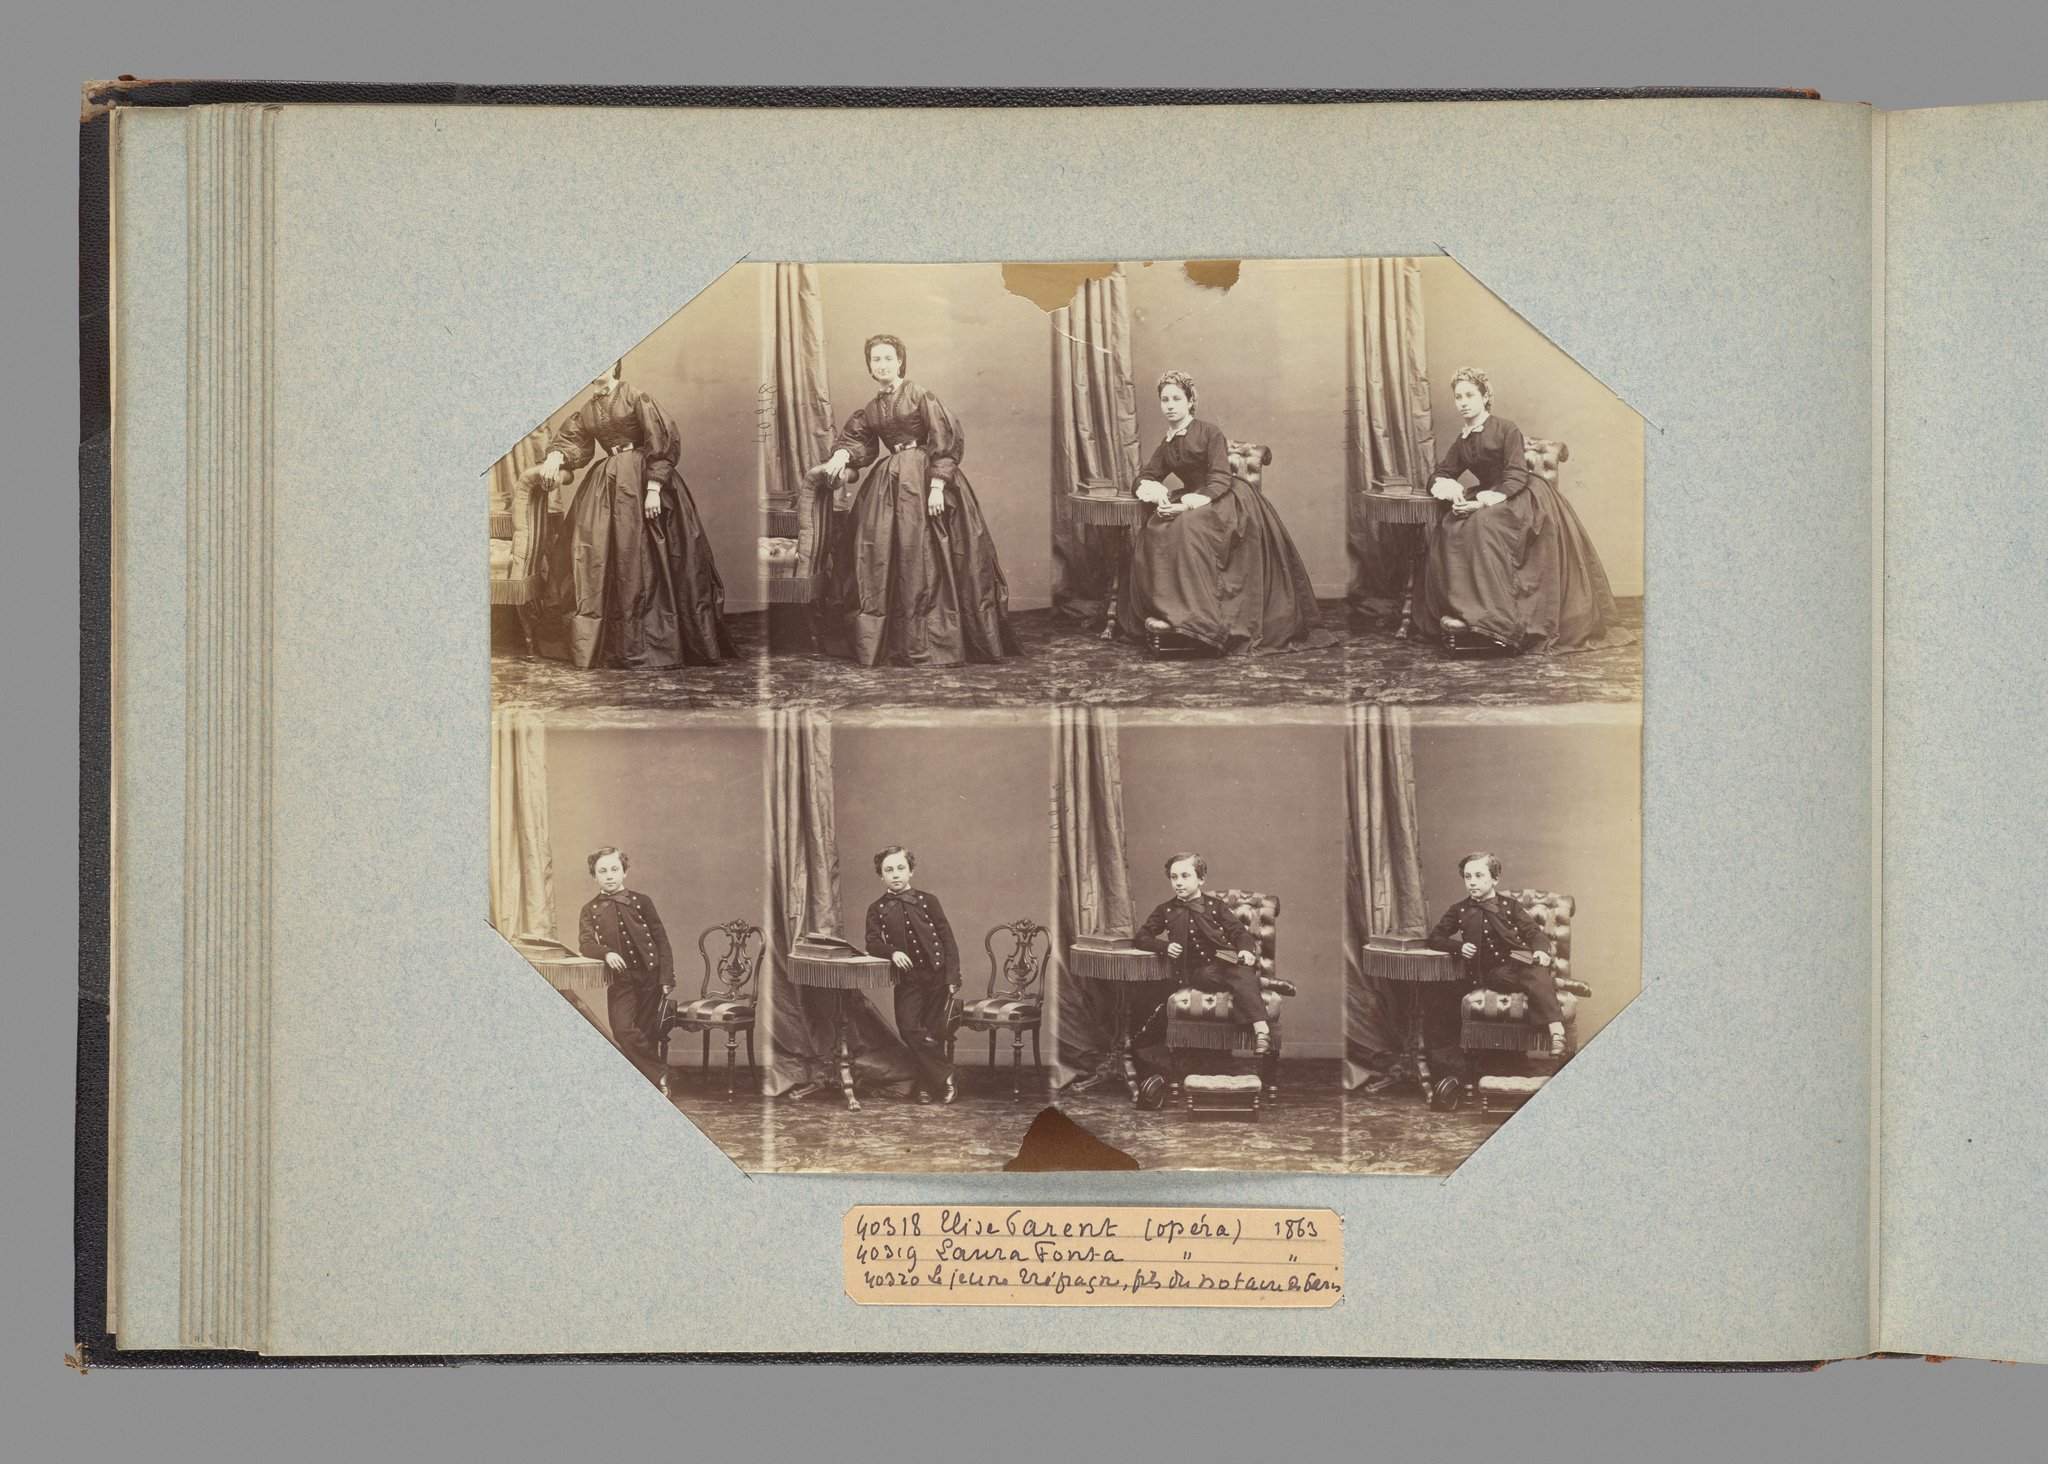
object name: photograph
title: Elise Parent; Laura Fonta; Le jeune [illegible]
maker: andré-adolphe-eugène disdéri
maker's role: artist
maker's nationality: french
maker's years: 1819-1889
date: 1863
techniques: albumen silver print, glass negative